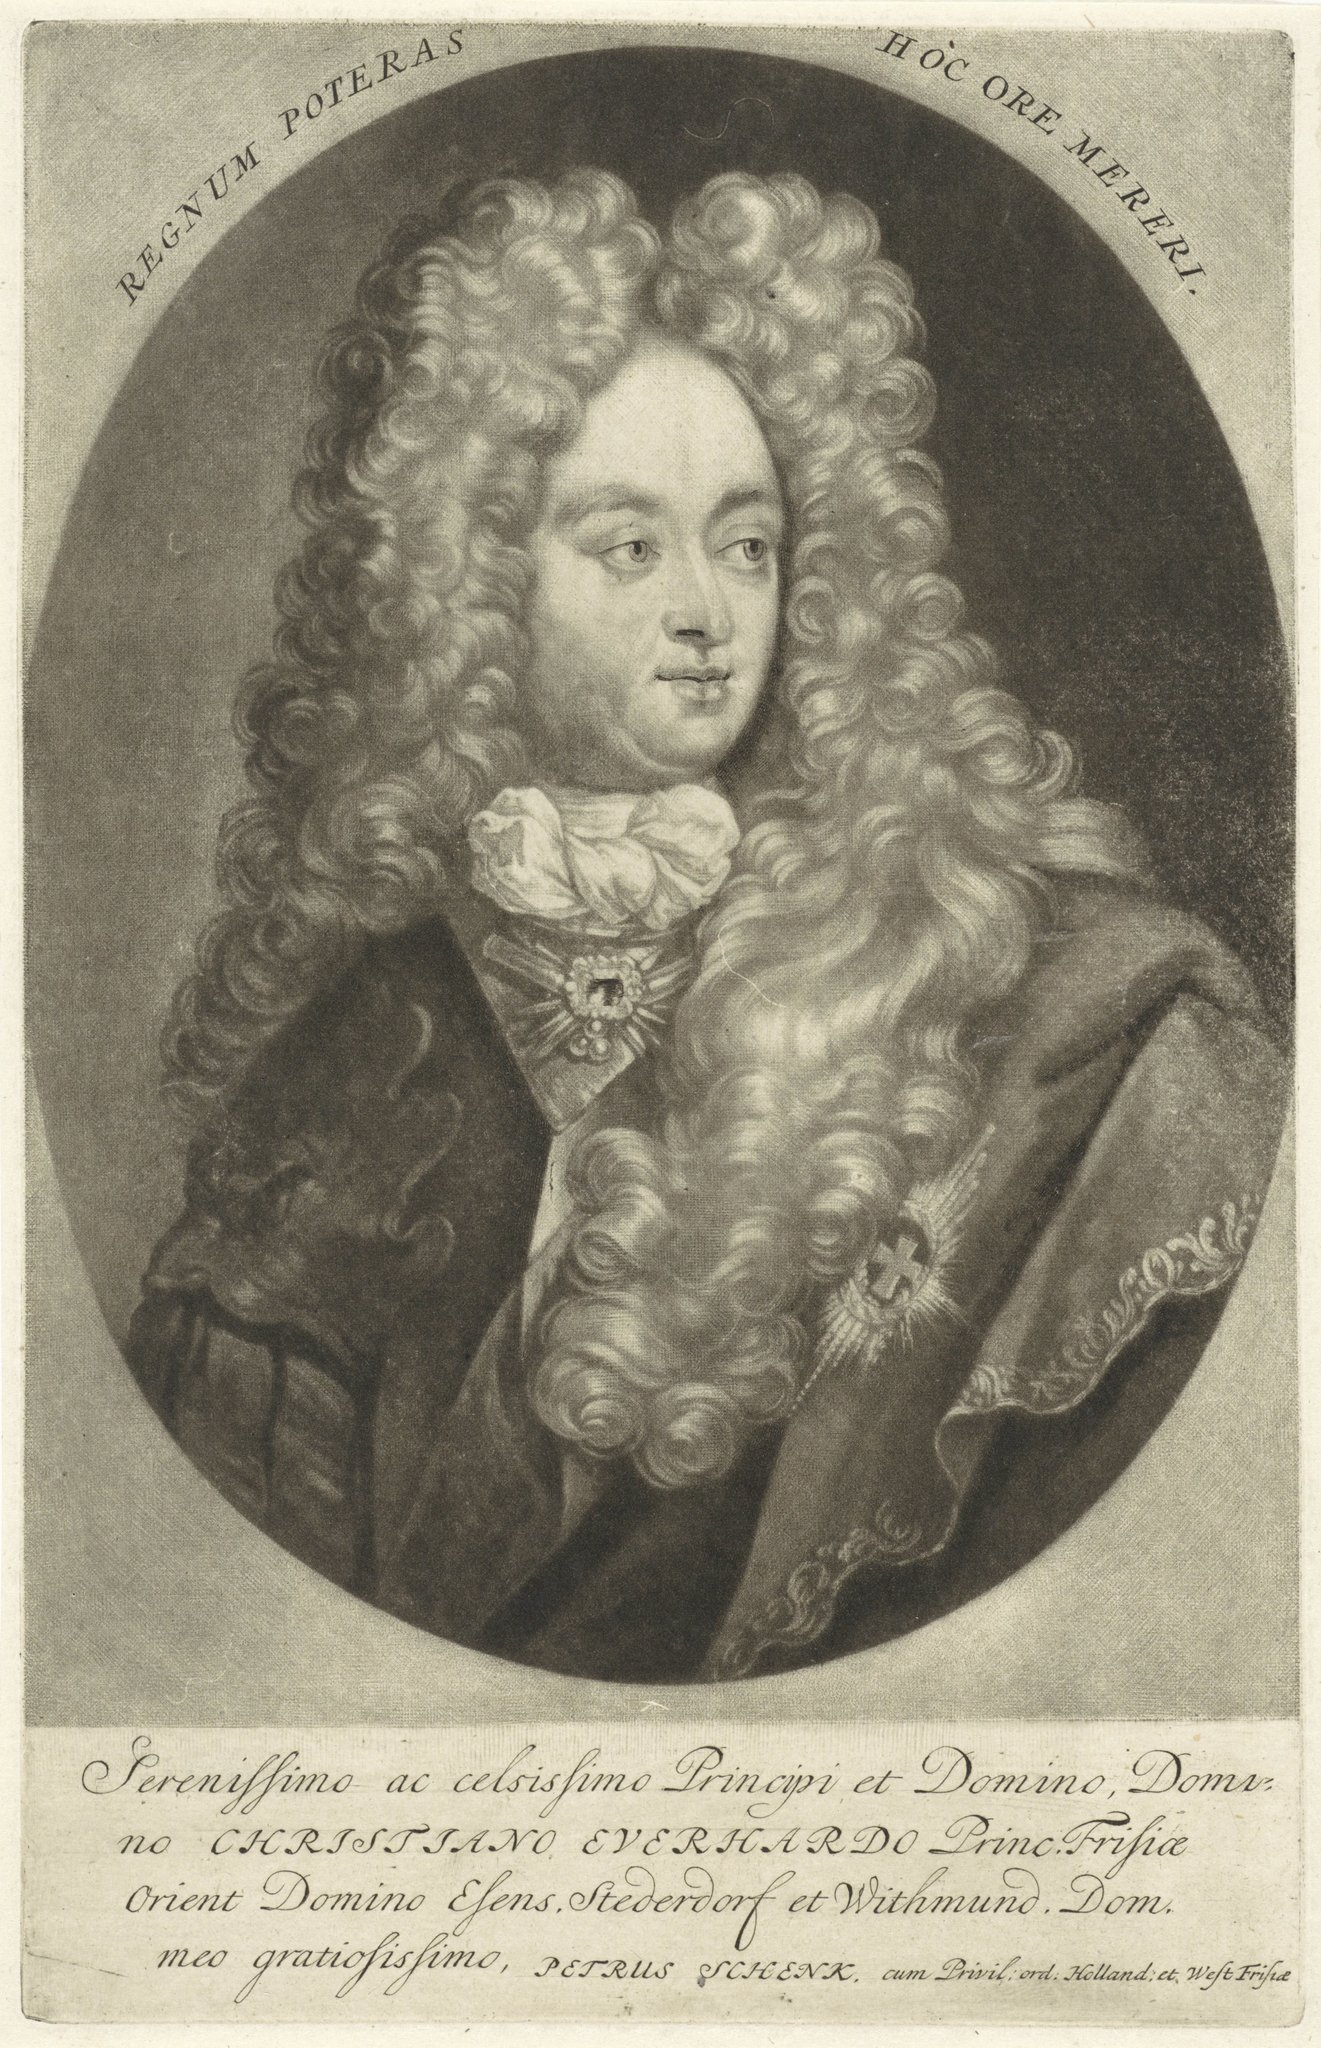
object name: print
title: Portret van Christiaan Eberhard van Oost-Friesland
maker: pieter schenk (i)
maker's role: print maker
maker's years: 1660-1711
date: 1670-1713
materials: paper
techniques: engraving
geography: amsterdam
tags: wig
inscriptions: collector's mark: Lugt 2228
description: De rijksvorst van Oost-Friesland, Christiaan Eberhard. Hij draagt een pruik.